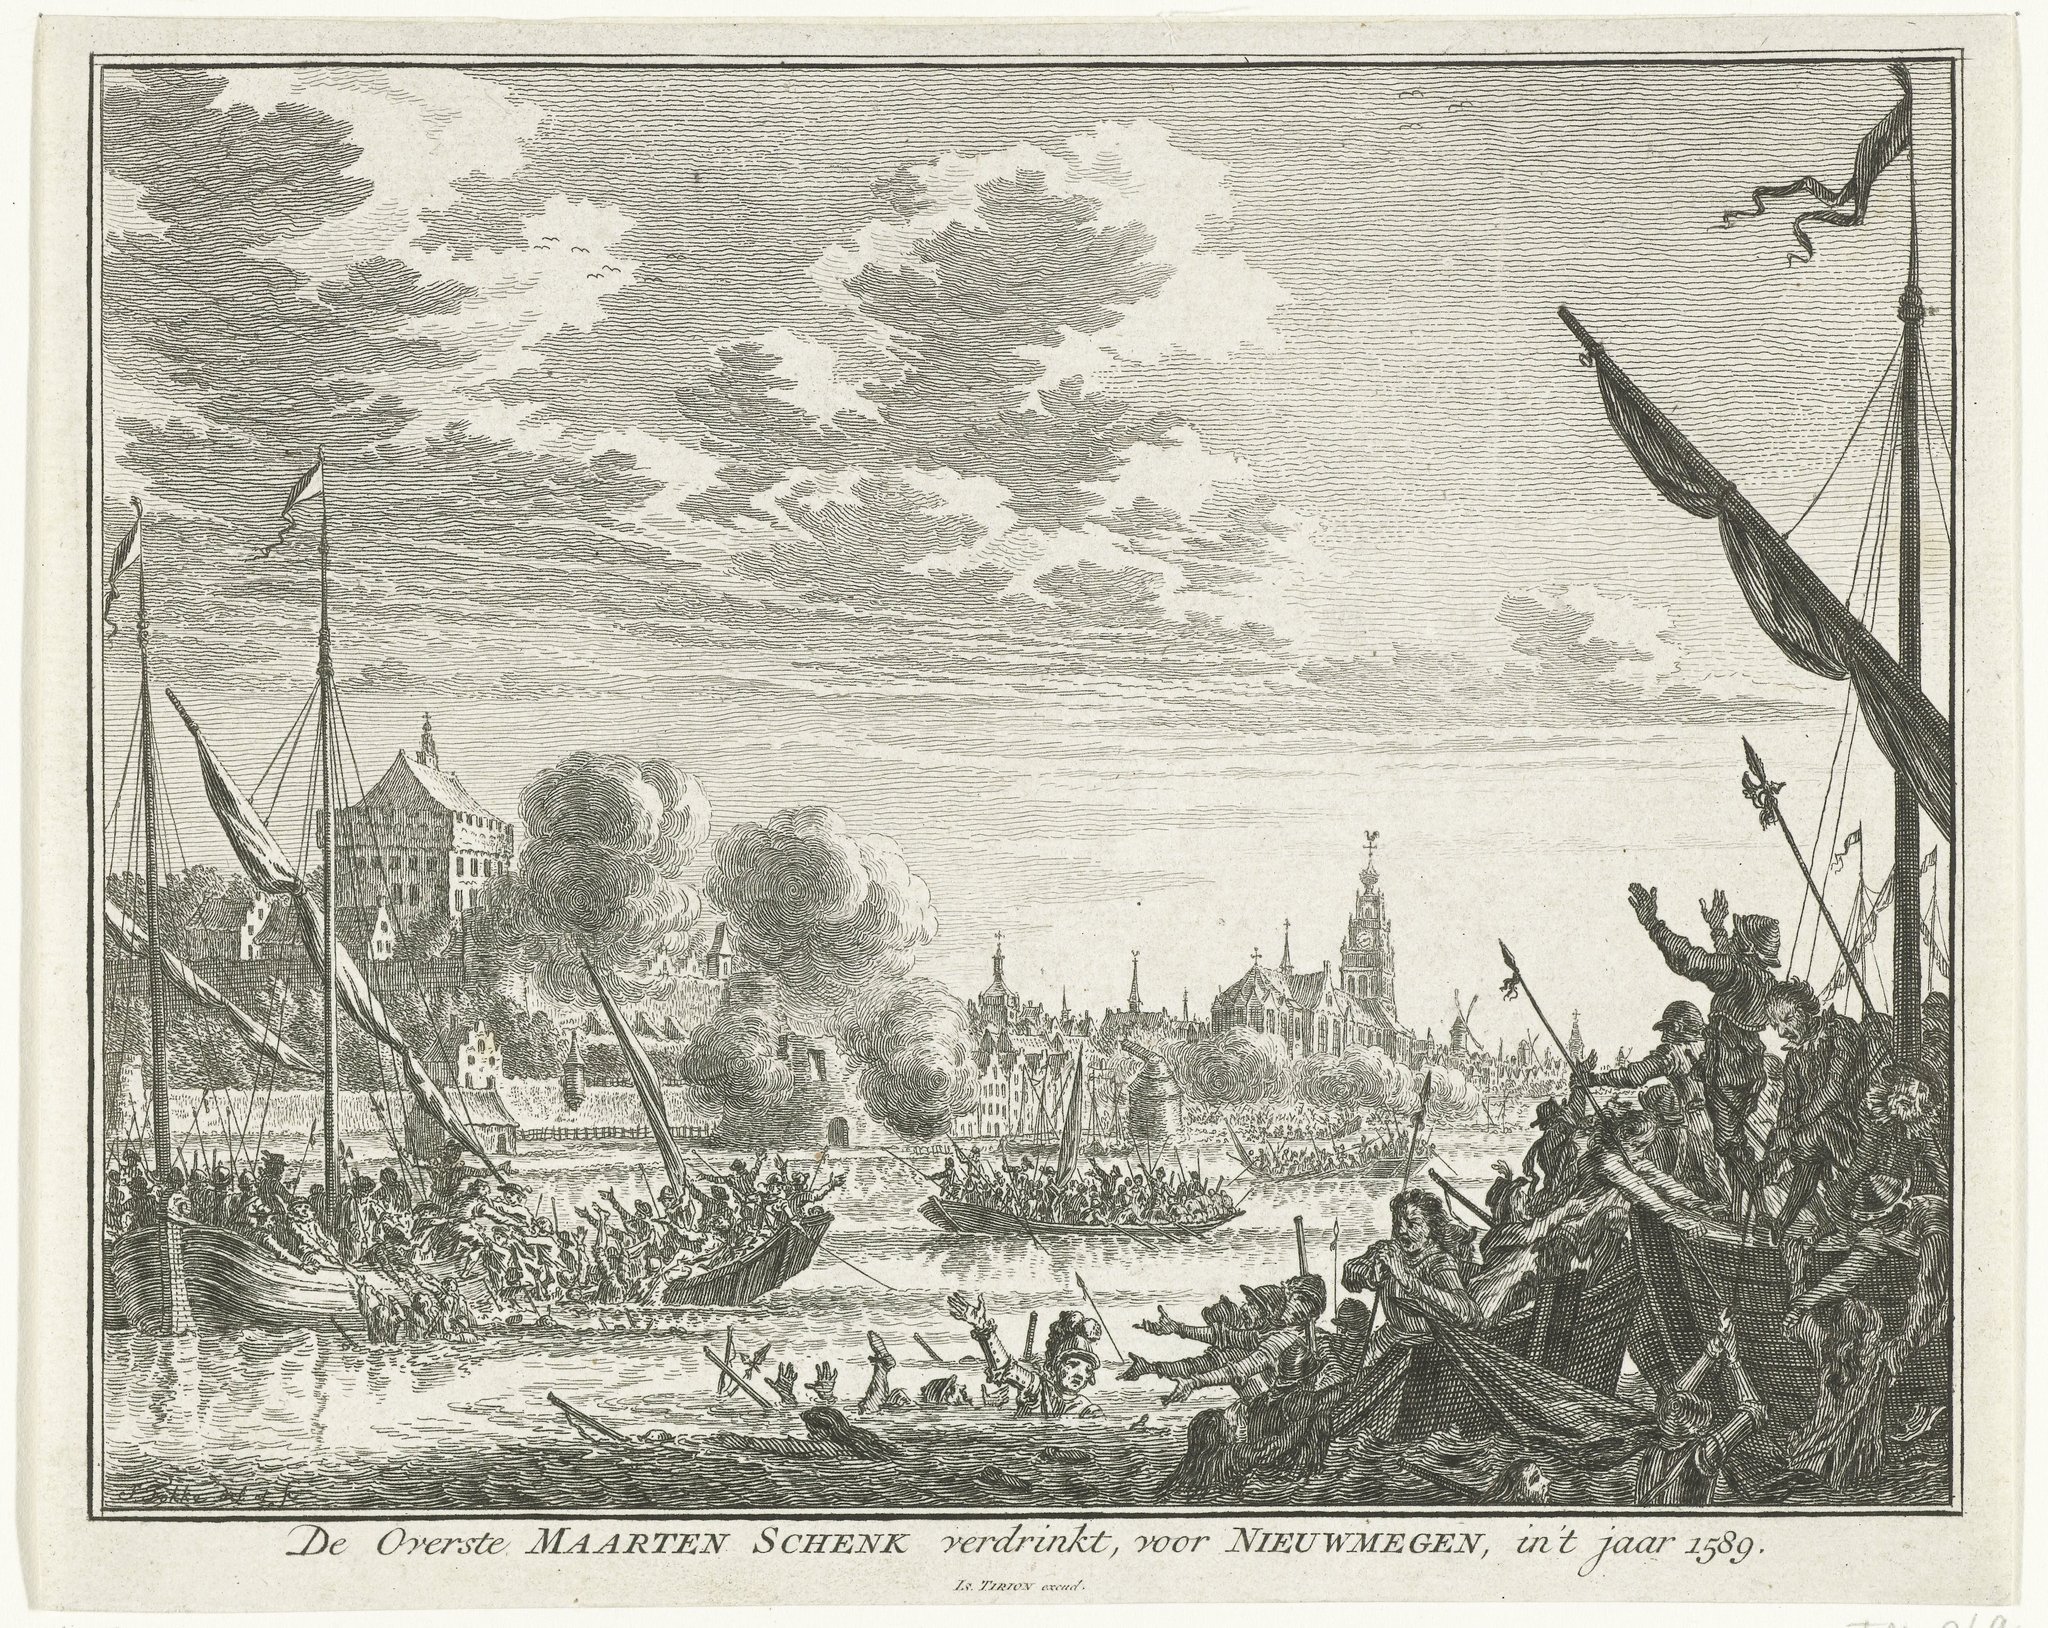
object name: history print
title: Aanslag van Maarten Schenck op Nijmegen, 1589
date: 1747-1759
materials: paper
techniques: etching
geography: northern netherlands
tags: nijmegen, drowning, shipwrecked person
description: Mislukte aanval door troepen onder Maarten Schenck op de stad Nijmegen, 10 augustus 1589. Episode uit de Keulse Oorlog. Bij het vluchten uit de stad verdrinkt Schenck in de Waal.